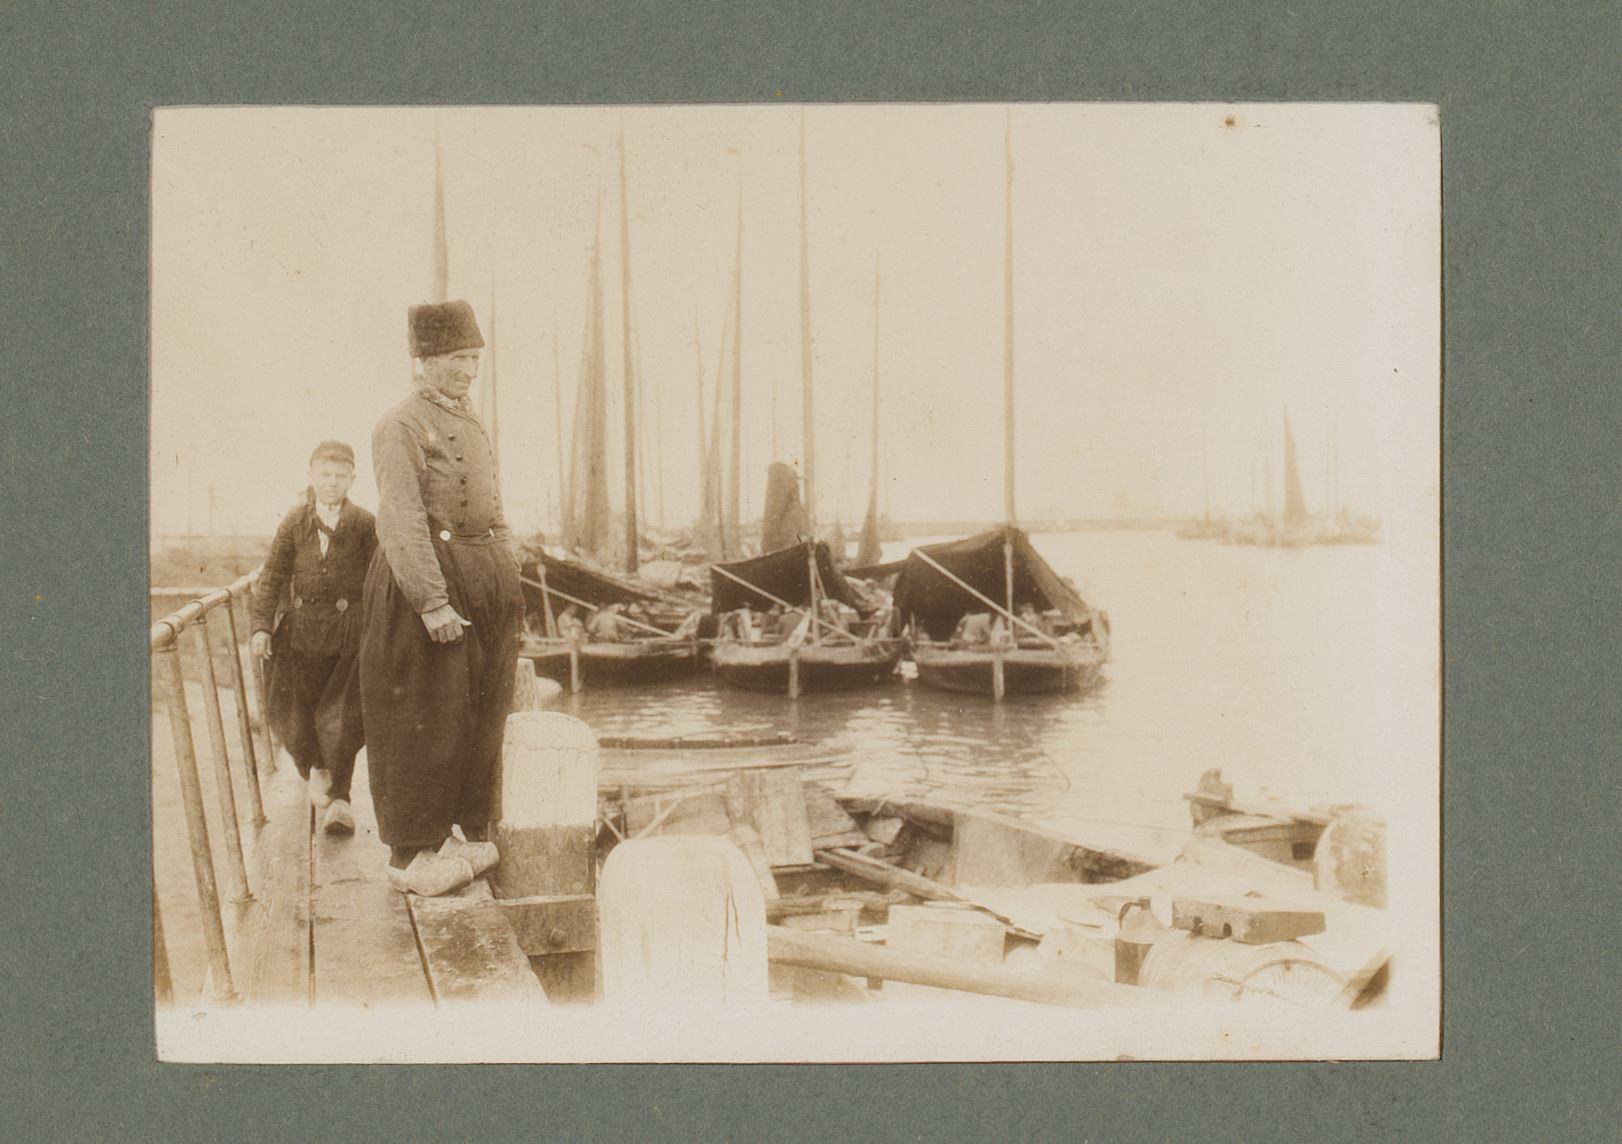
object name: album leaf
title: Man en jongen in klederdracht, op een steiger in een haven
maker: george hidderley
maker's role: fotograaf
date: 1920-1940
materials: photographic support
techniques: gelatin silver print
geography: netherlands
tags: historical persons, folk costume, regional costume, pier, quay, wharf